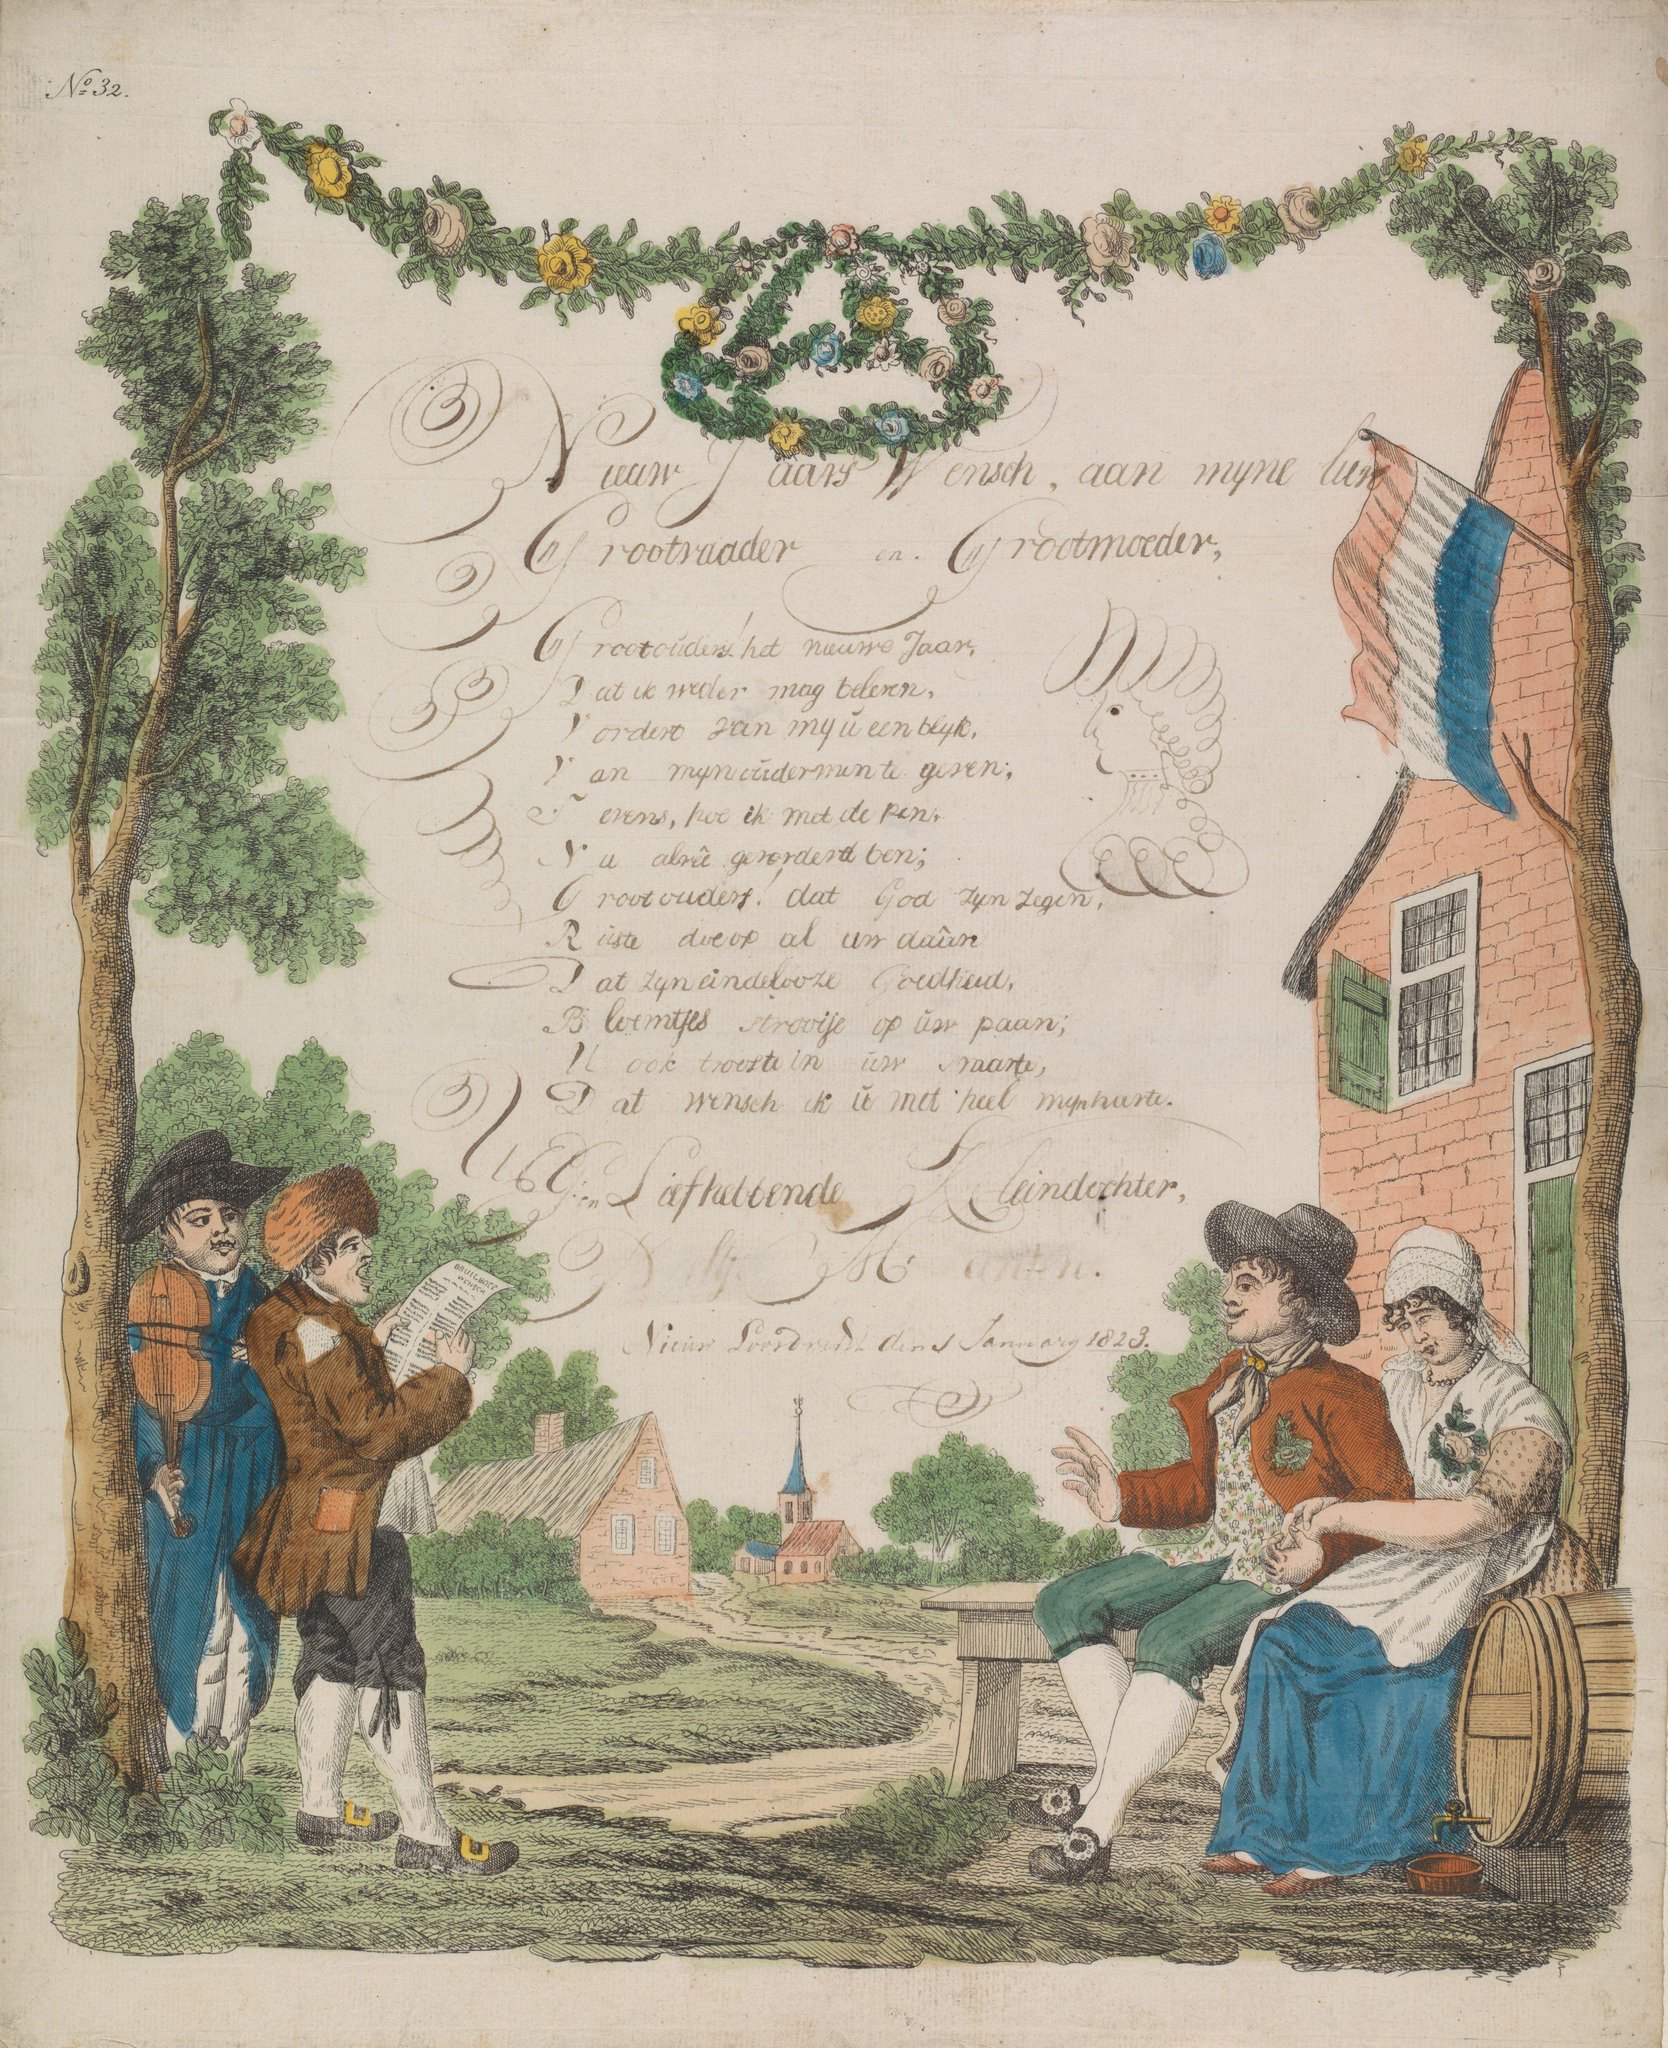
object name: print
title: Wensbrief met muzikanten en een bruidspaar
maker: Anonymous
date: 1829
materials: ink, paper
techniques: calligraphy, colour, etching, pen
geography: netherlands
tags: musician, musician - cc - out of doors, marriage, married couple, 'matrimonium', serenade to the beloved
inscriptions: collector's mark: Lugt 2760, inscription: ‘Nieuw jaars ensch, aan myne lieve / Grootvader en. grootmoeder, / Grootoúders! het nieuwe jaar ...’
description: Wensbrief met beschreven cartouche binnen een decoratief kader met een voorstelling van muzikanten die een bruidspaar een serenade brengen. Handgeschreven bericht in kalligrafie (Nieuwjaarswens) een meisje aan haar grootvader en grootmoeder. Genummerd linksboven: No. 32. Naam auteur weggevaagd.